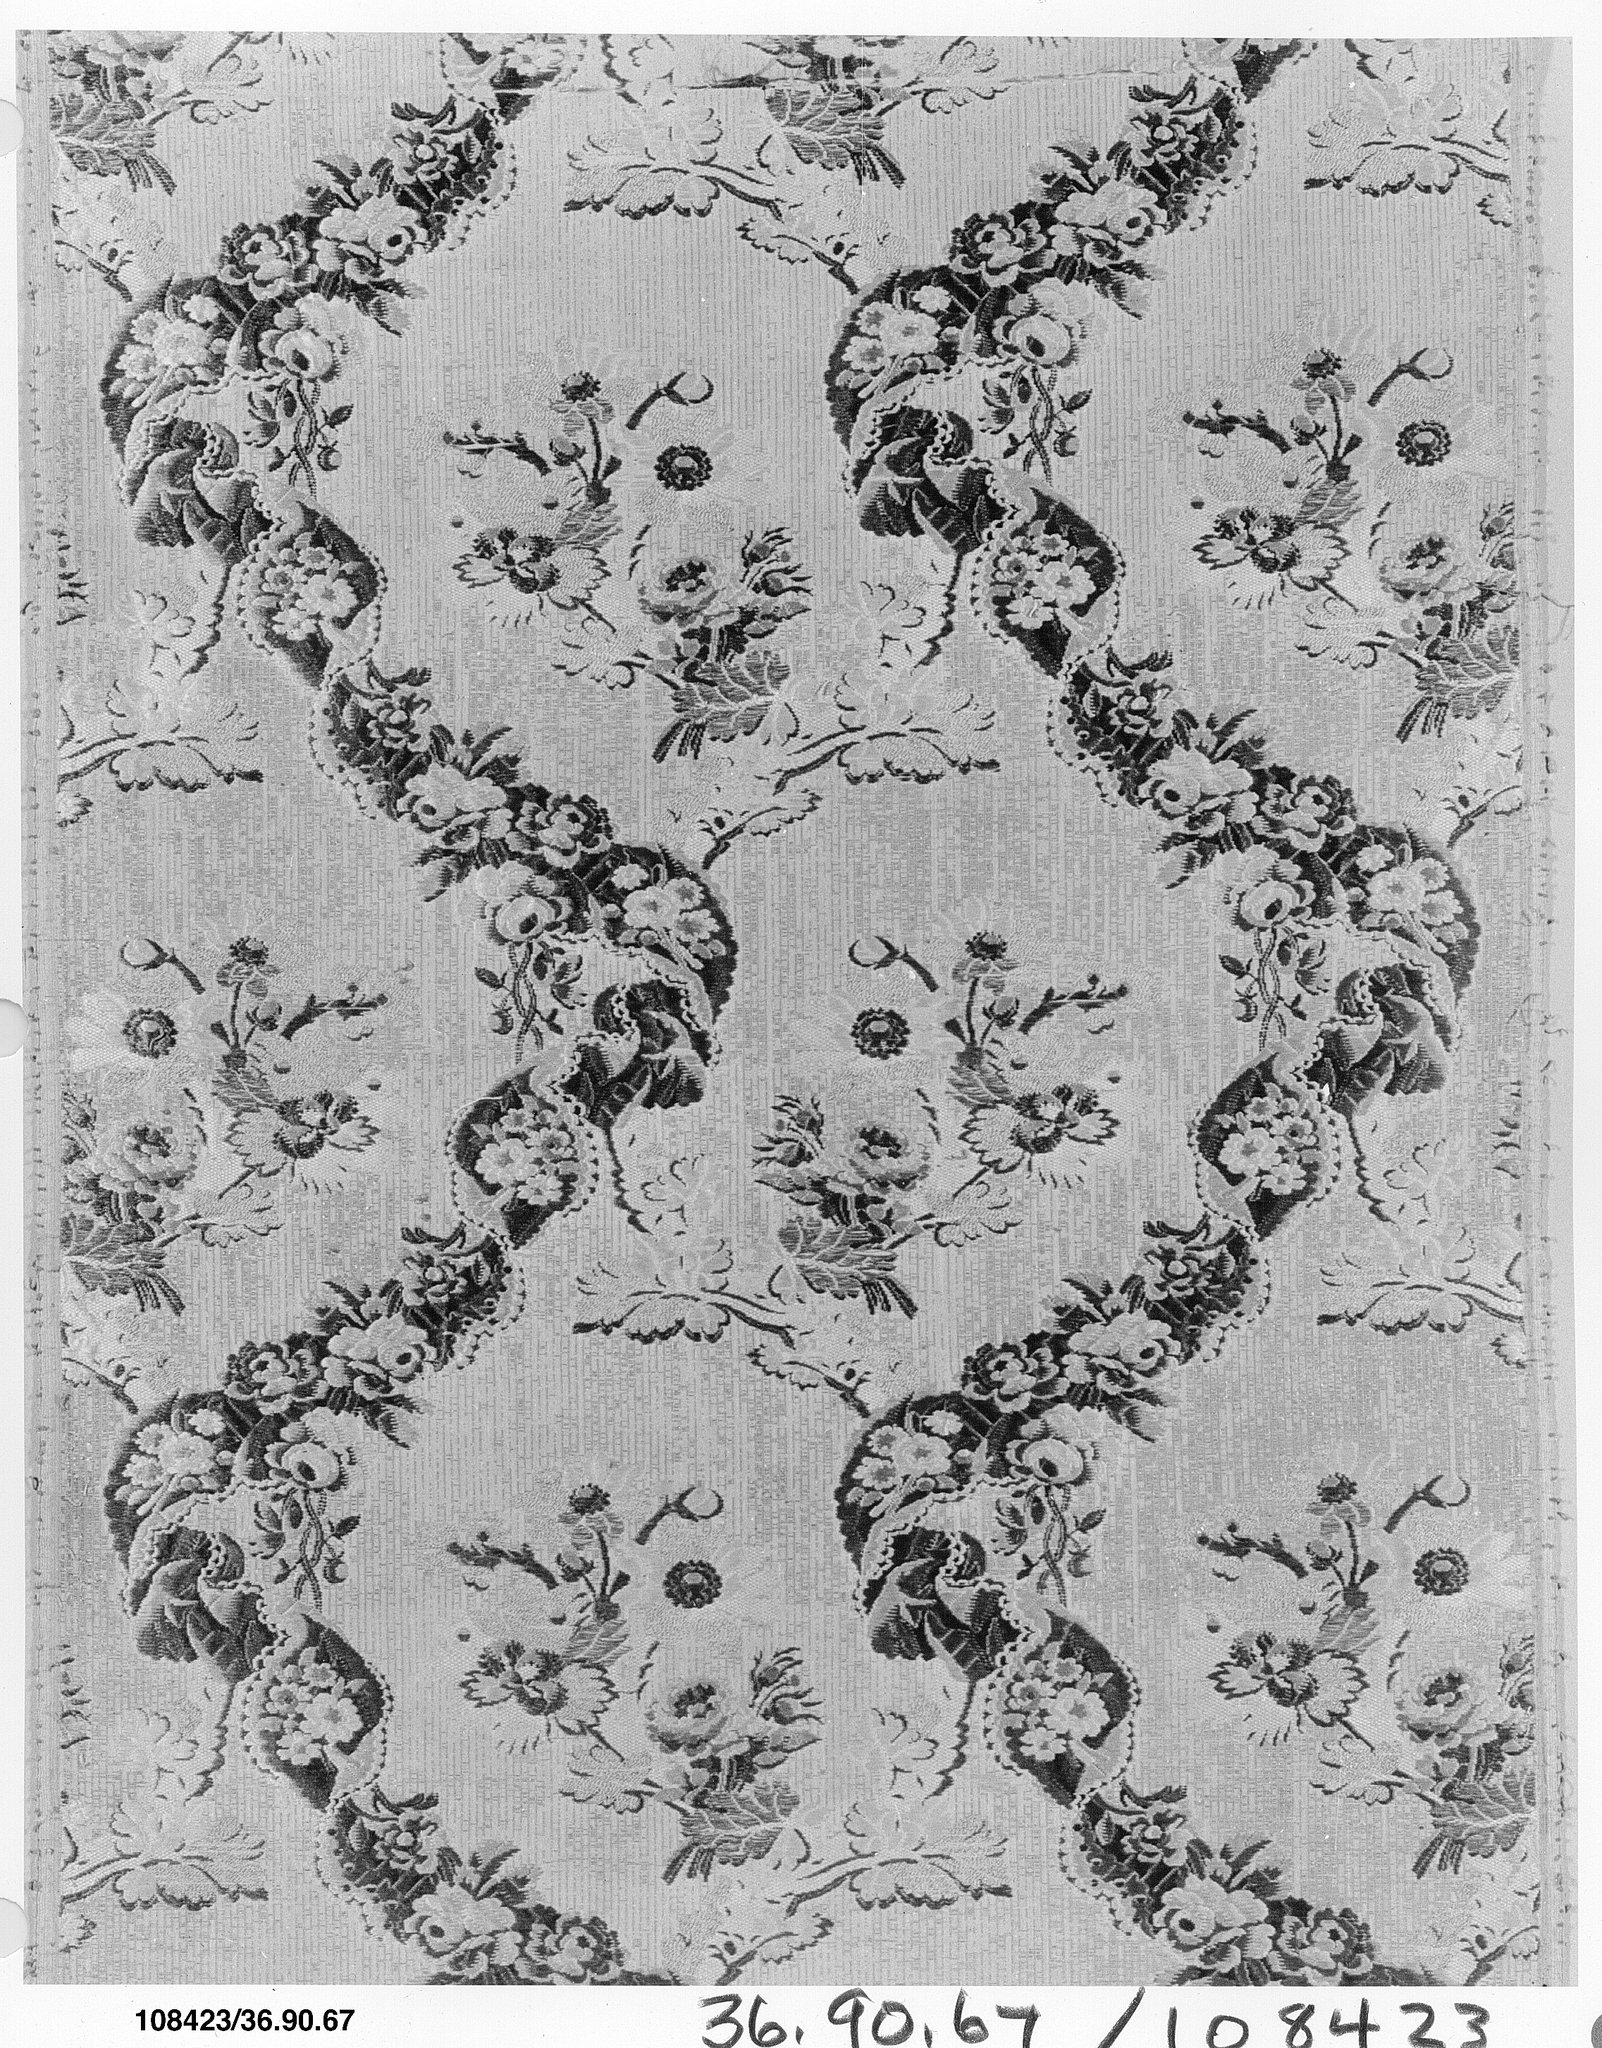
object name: piece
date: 1734-1766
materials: metal thread, silk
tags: flowers